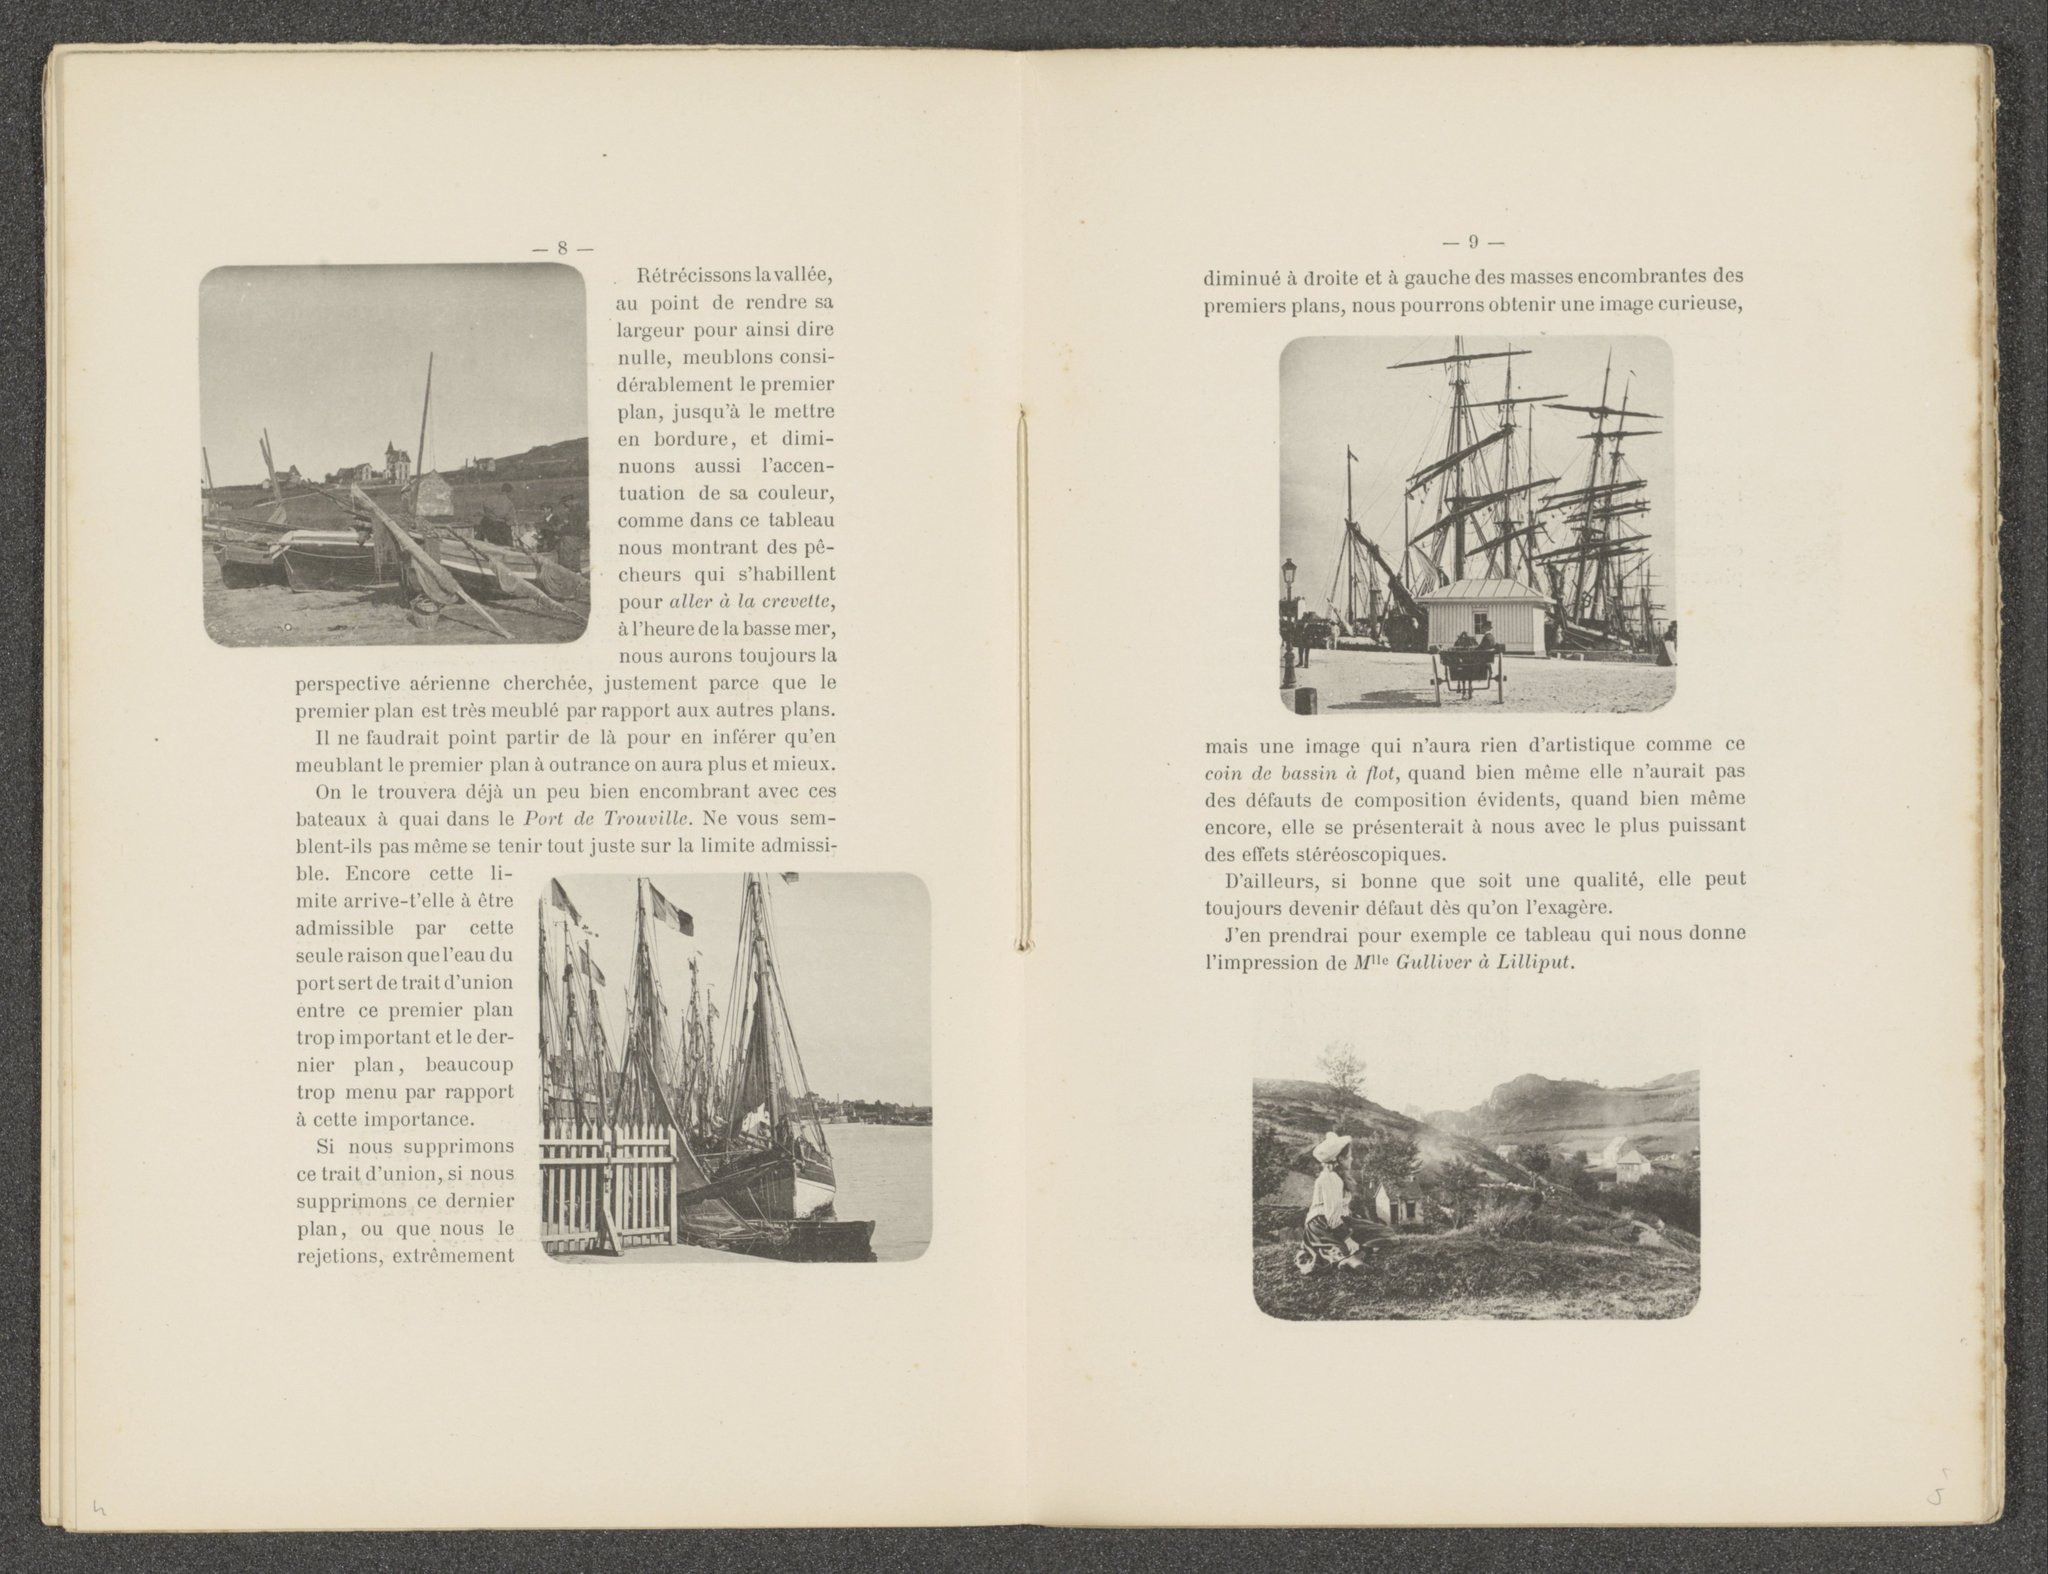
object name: photomechanical print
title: Boten en schepen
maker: Anonymous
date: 1886-1896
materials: paper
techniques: photograph, printing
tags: ships (in general), pier, quay, wharf, ships, boats on land, beached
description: Boven boten op een strand, onder schepen langs een kade.